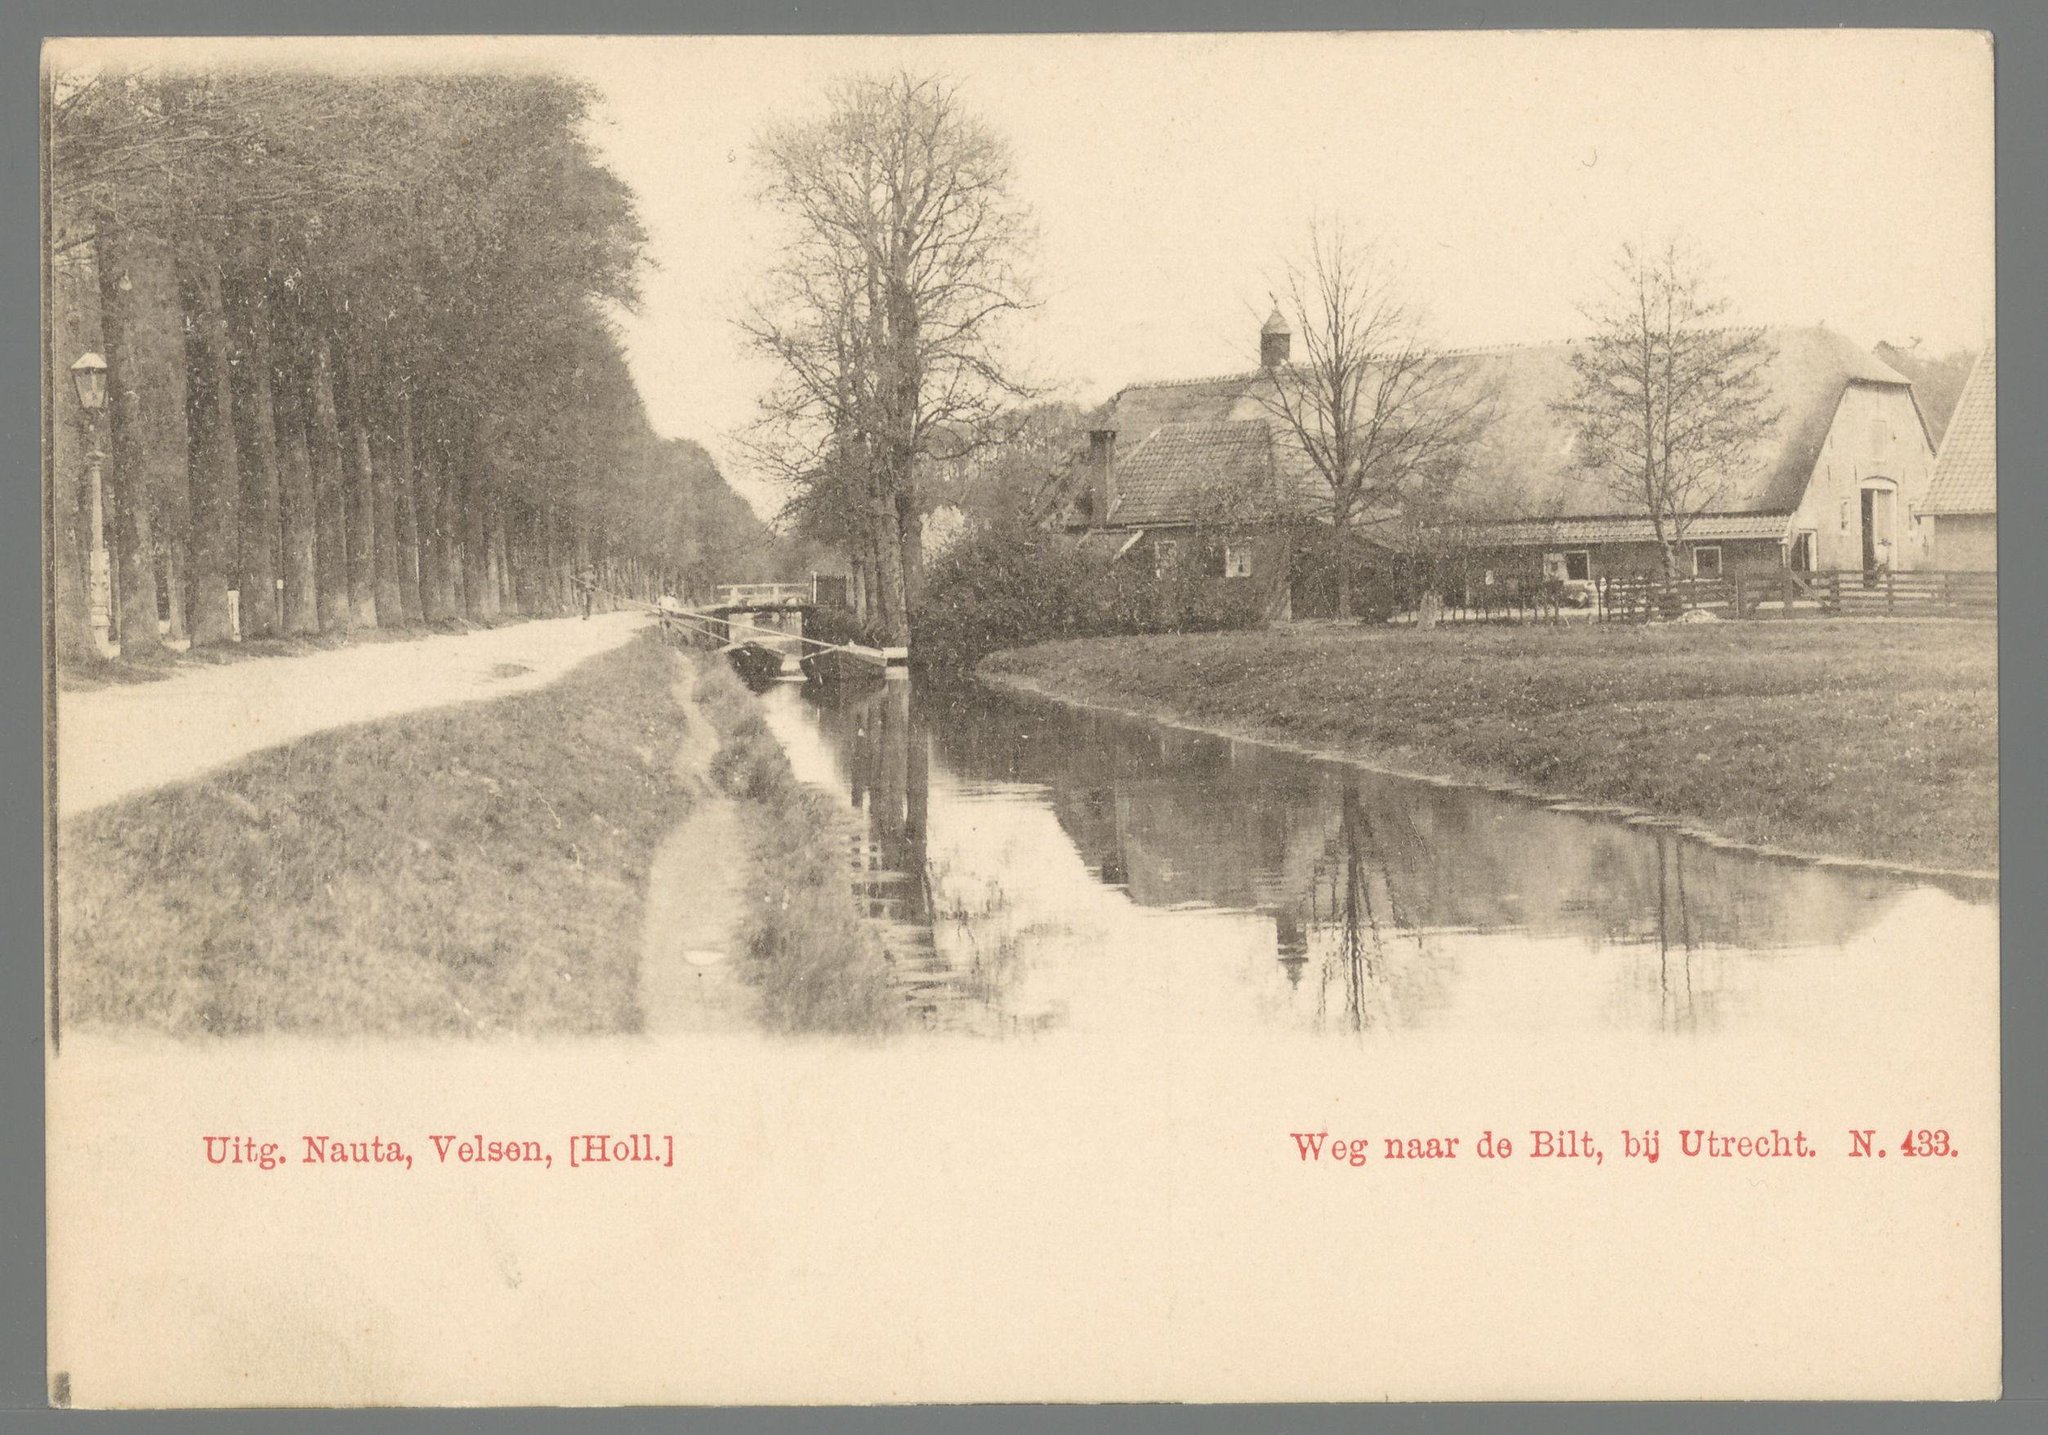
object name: ansichtkaart, prentbriefkaart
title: Weg naar de Bilt, bij Utrecht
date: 1897-1905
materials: cardboard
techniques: photograph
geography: de bilt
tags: canals, waters (in village), farm (building)